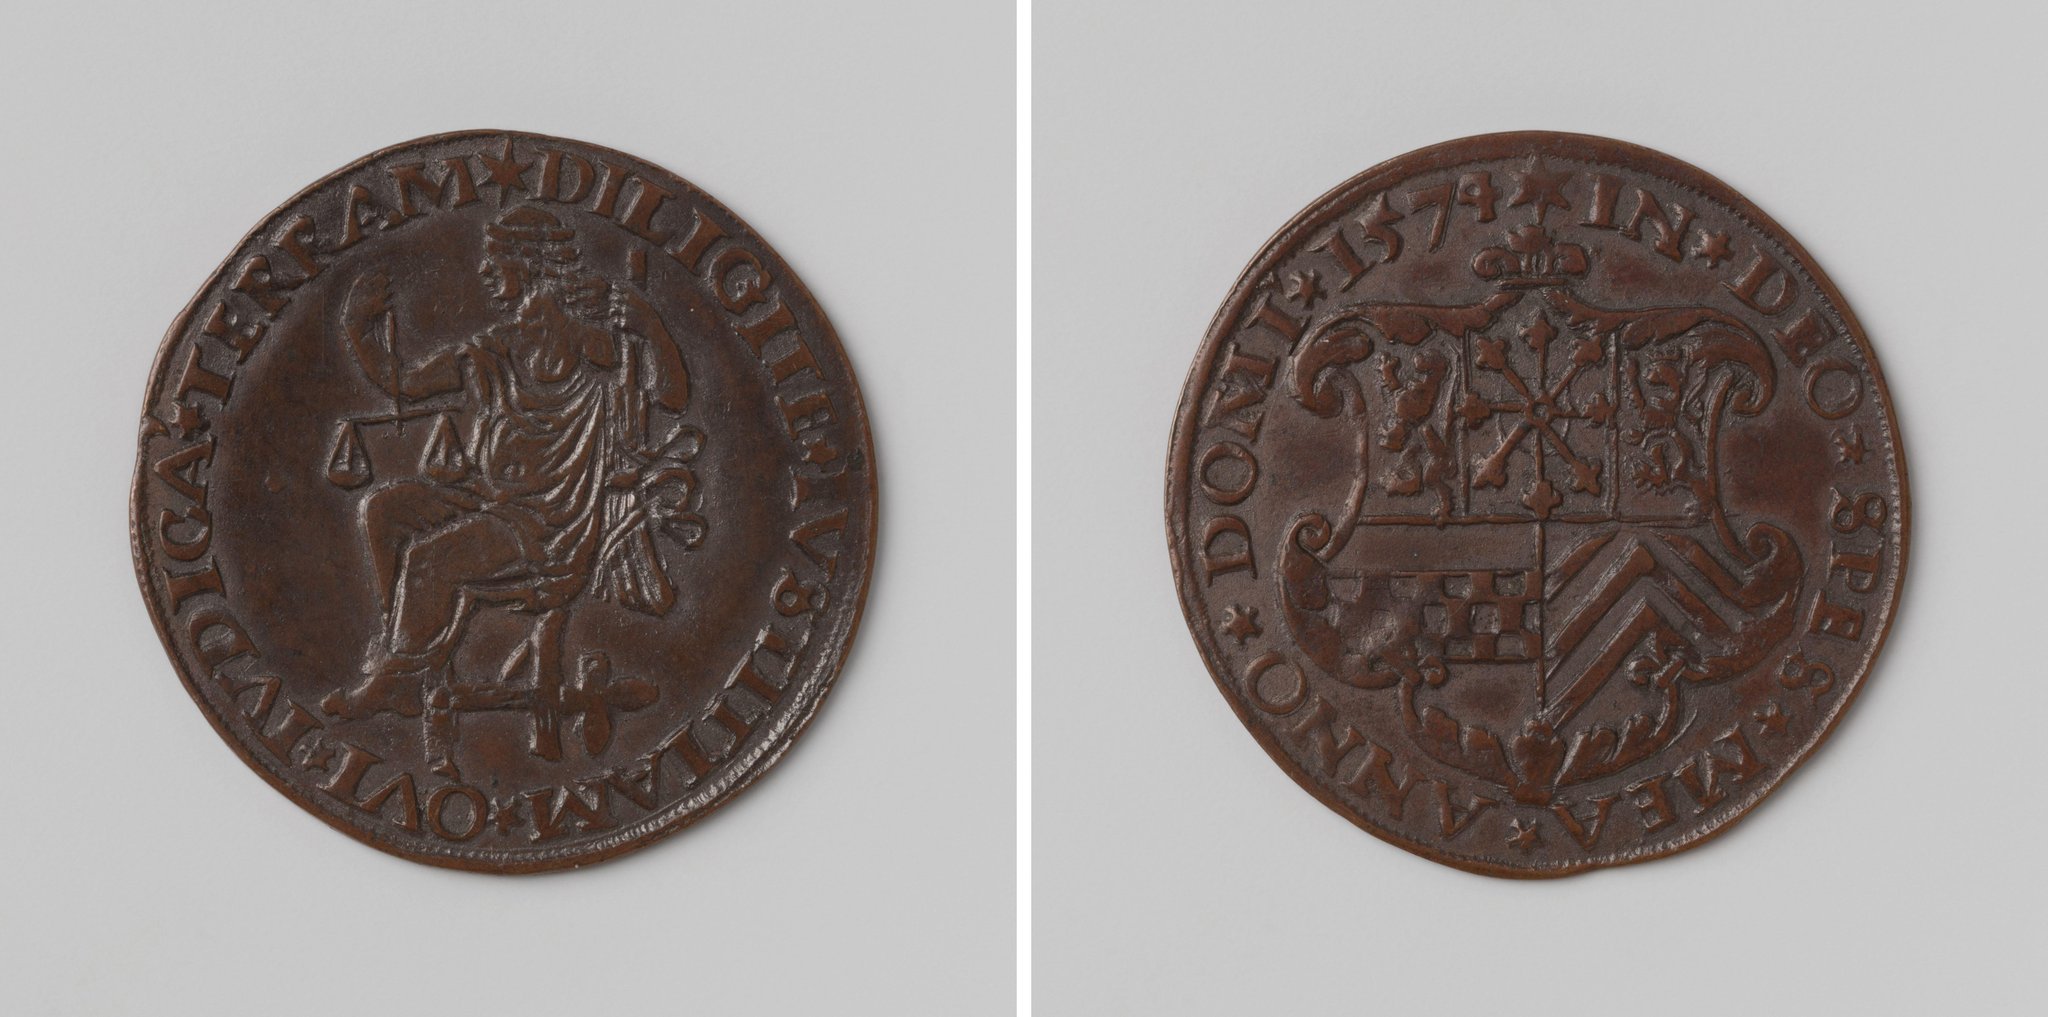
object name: jeton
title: Willem II, hertog van Gulik en Kleef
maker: Anonymous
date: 1574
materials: copper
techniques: striking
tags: hertog, willem ii (hertog van gelre)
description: Koperen penning. Voorzijde: Rechtvaardigheid met blinddoek voor ogen en weegschaal in hand, zittend op stoel binnen omschrift. Keerzijde: wapenschild binnen omschrift